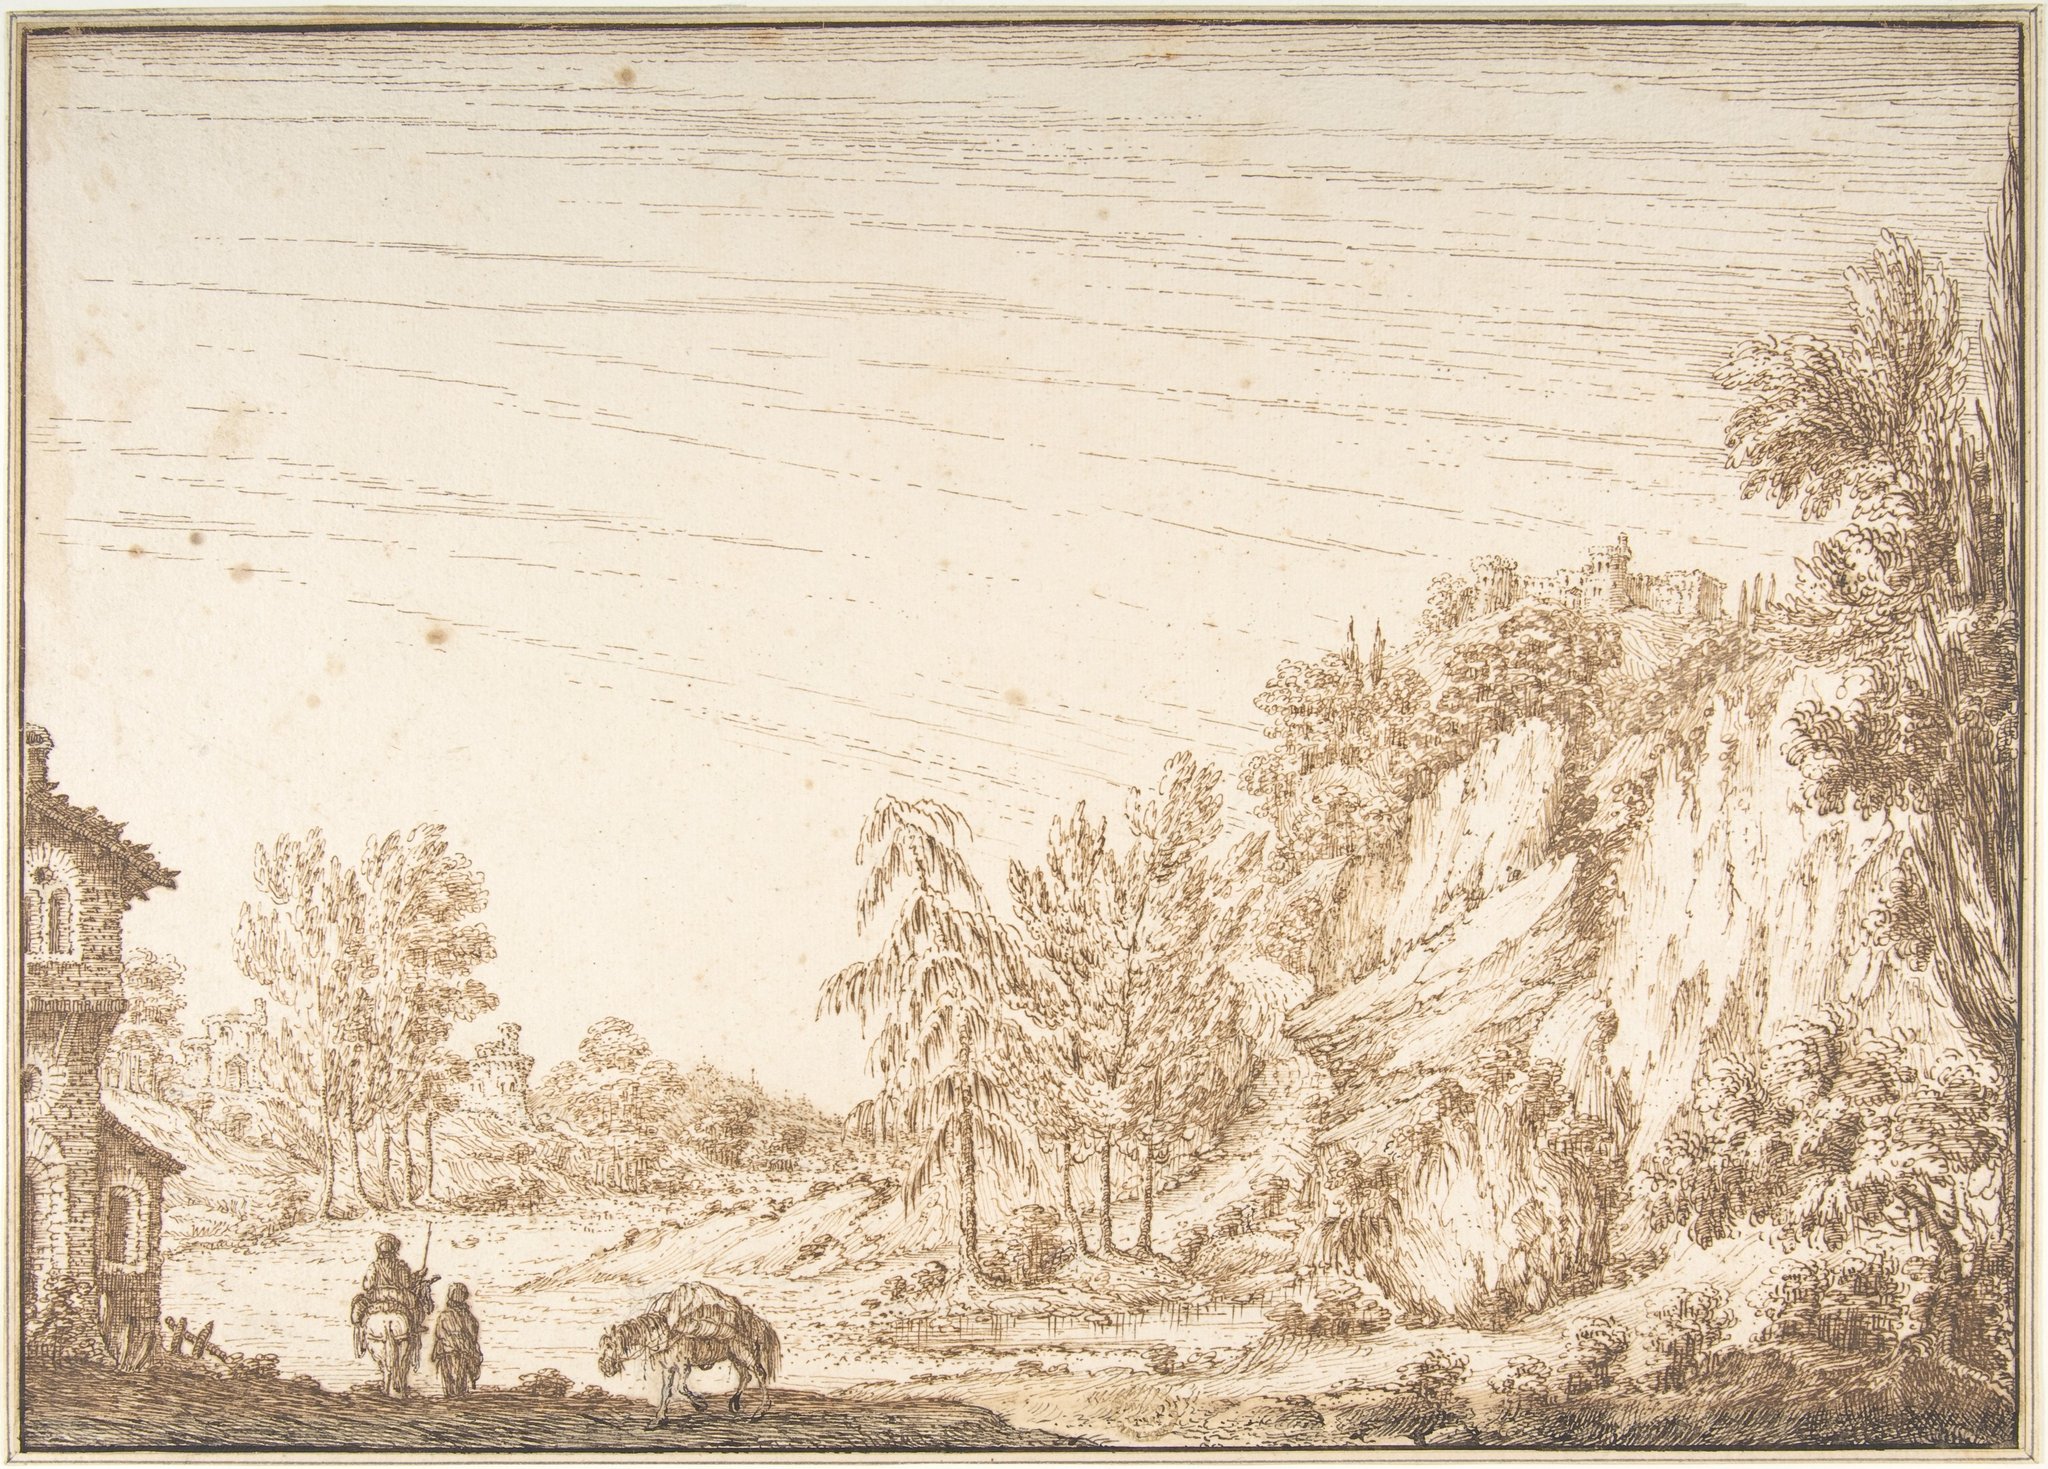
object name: drawing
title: Landscape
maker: anonymous, flemish, 17th century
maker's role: artist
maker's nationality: flemish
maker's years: 1600-1700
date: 1601-1700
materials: ink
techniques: pen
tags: animals,hills,landscapes